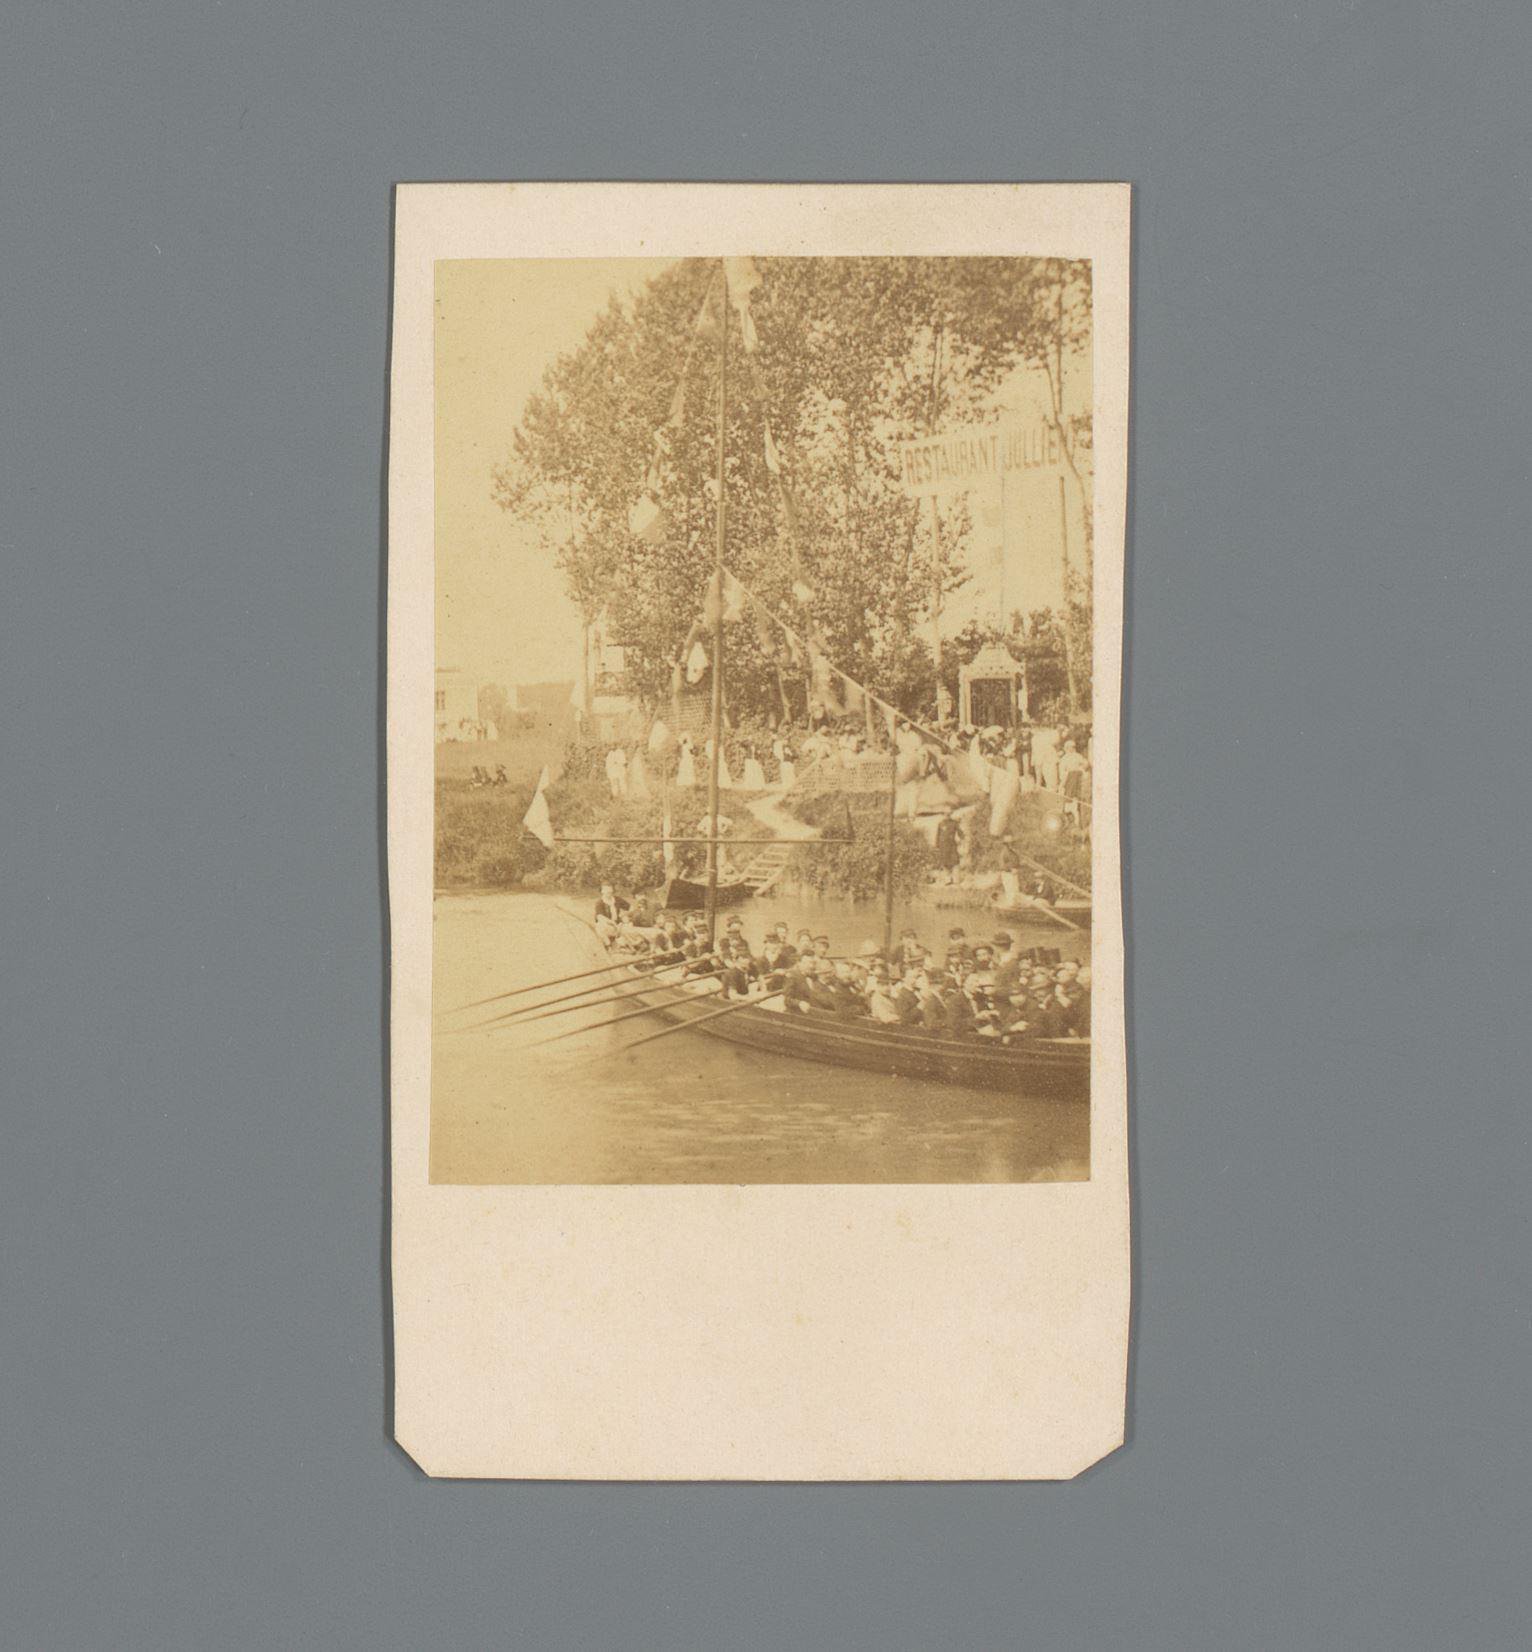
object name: carte de visite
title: Gezelschap in feestelijke boot, Joinville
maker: Anonymous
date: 1865-1870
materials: cardboard, paper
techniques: albumen print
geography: joinville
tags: periodic celebrations, popular feasts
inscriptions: inscription: ‘fêtes de Joinville’